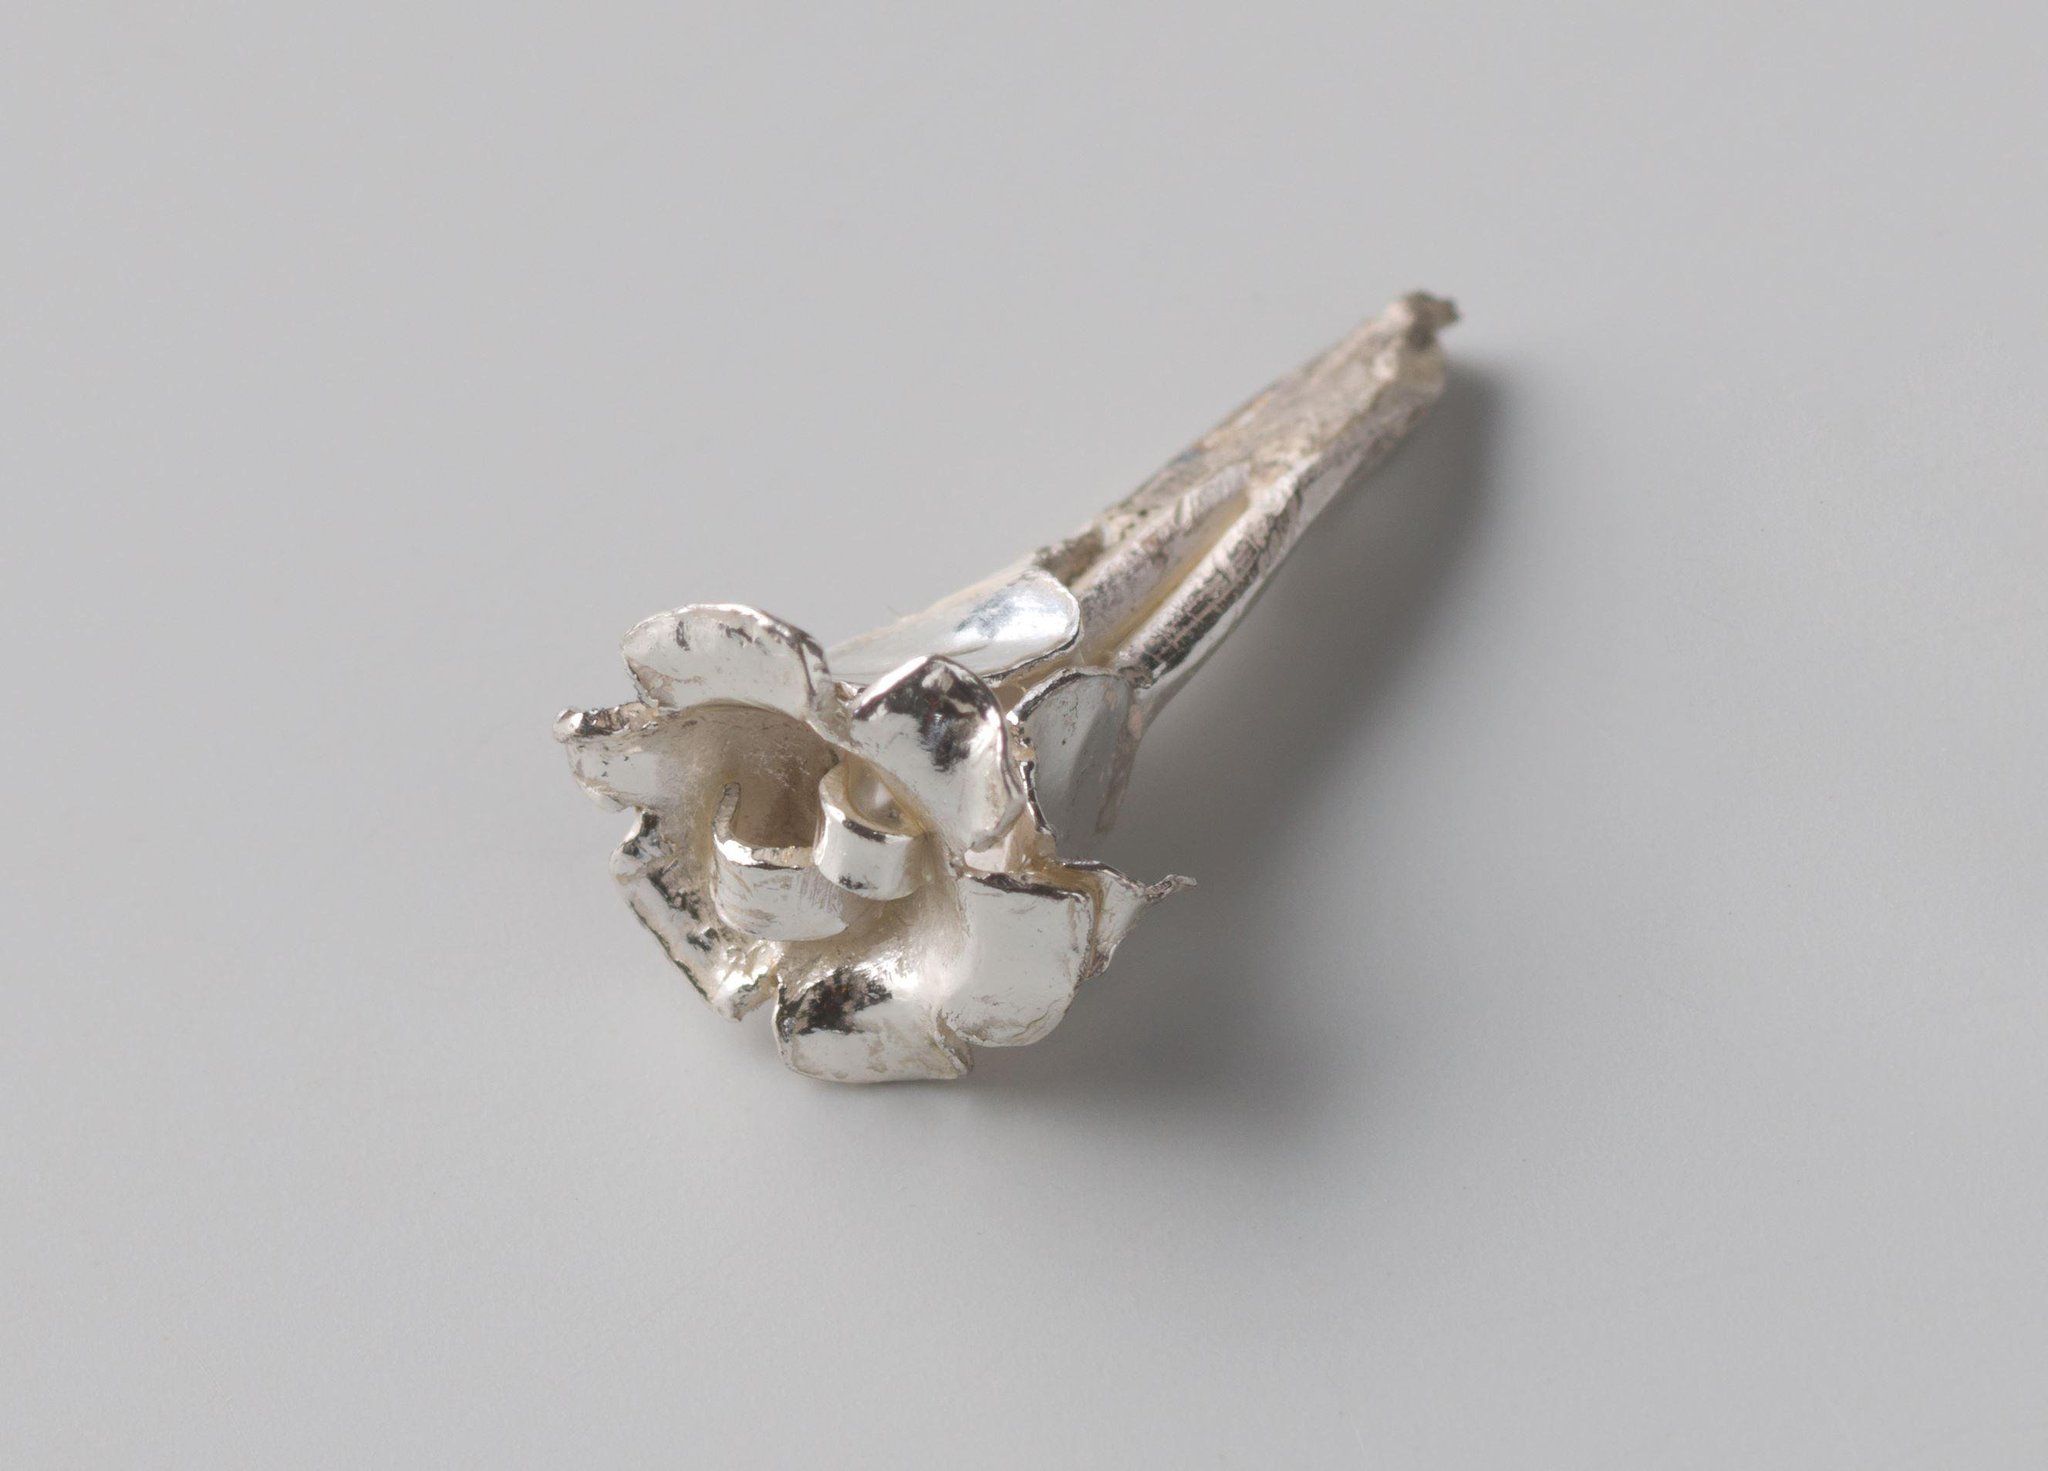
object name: tafelmiddenstuk, milieu de table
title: Fragment van middenstuk, miniatuur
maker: Anonymous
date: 1775-1795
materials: silver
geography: netherlands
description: Afgebroken bloemfragment van middenstuk van zilver, op piedestal, met portretmedaillons.